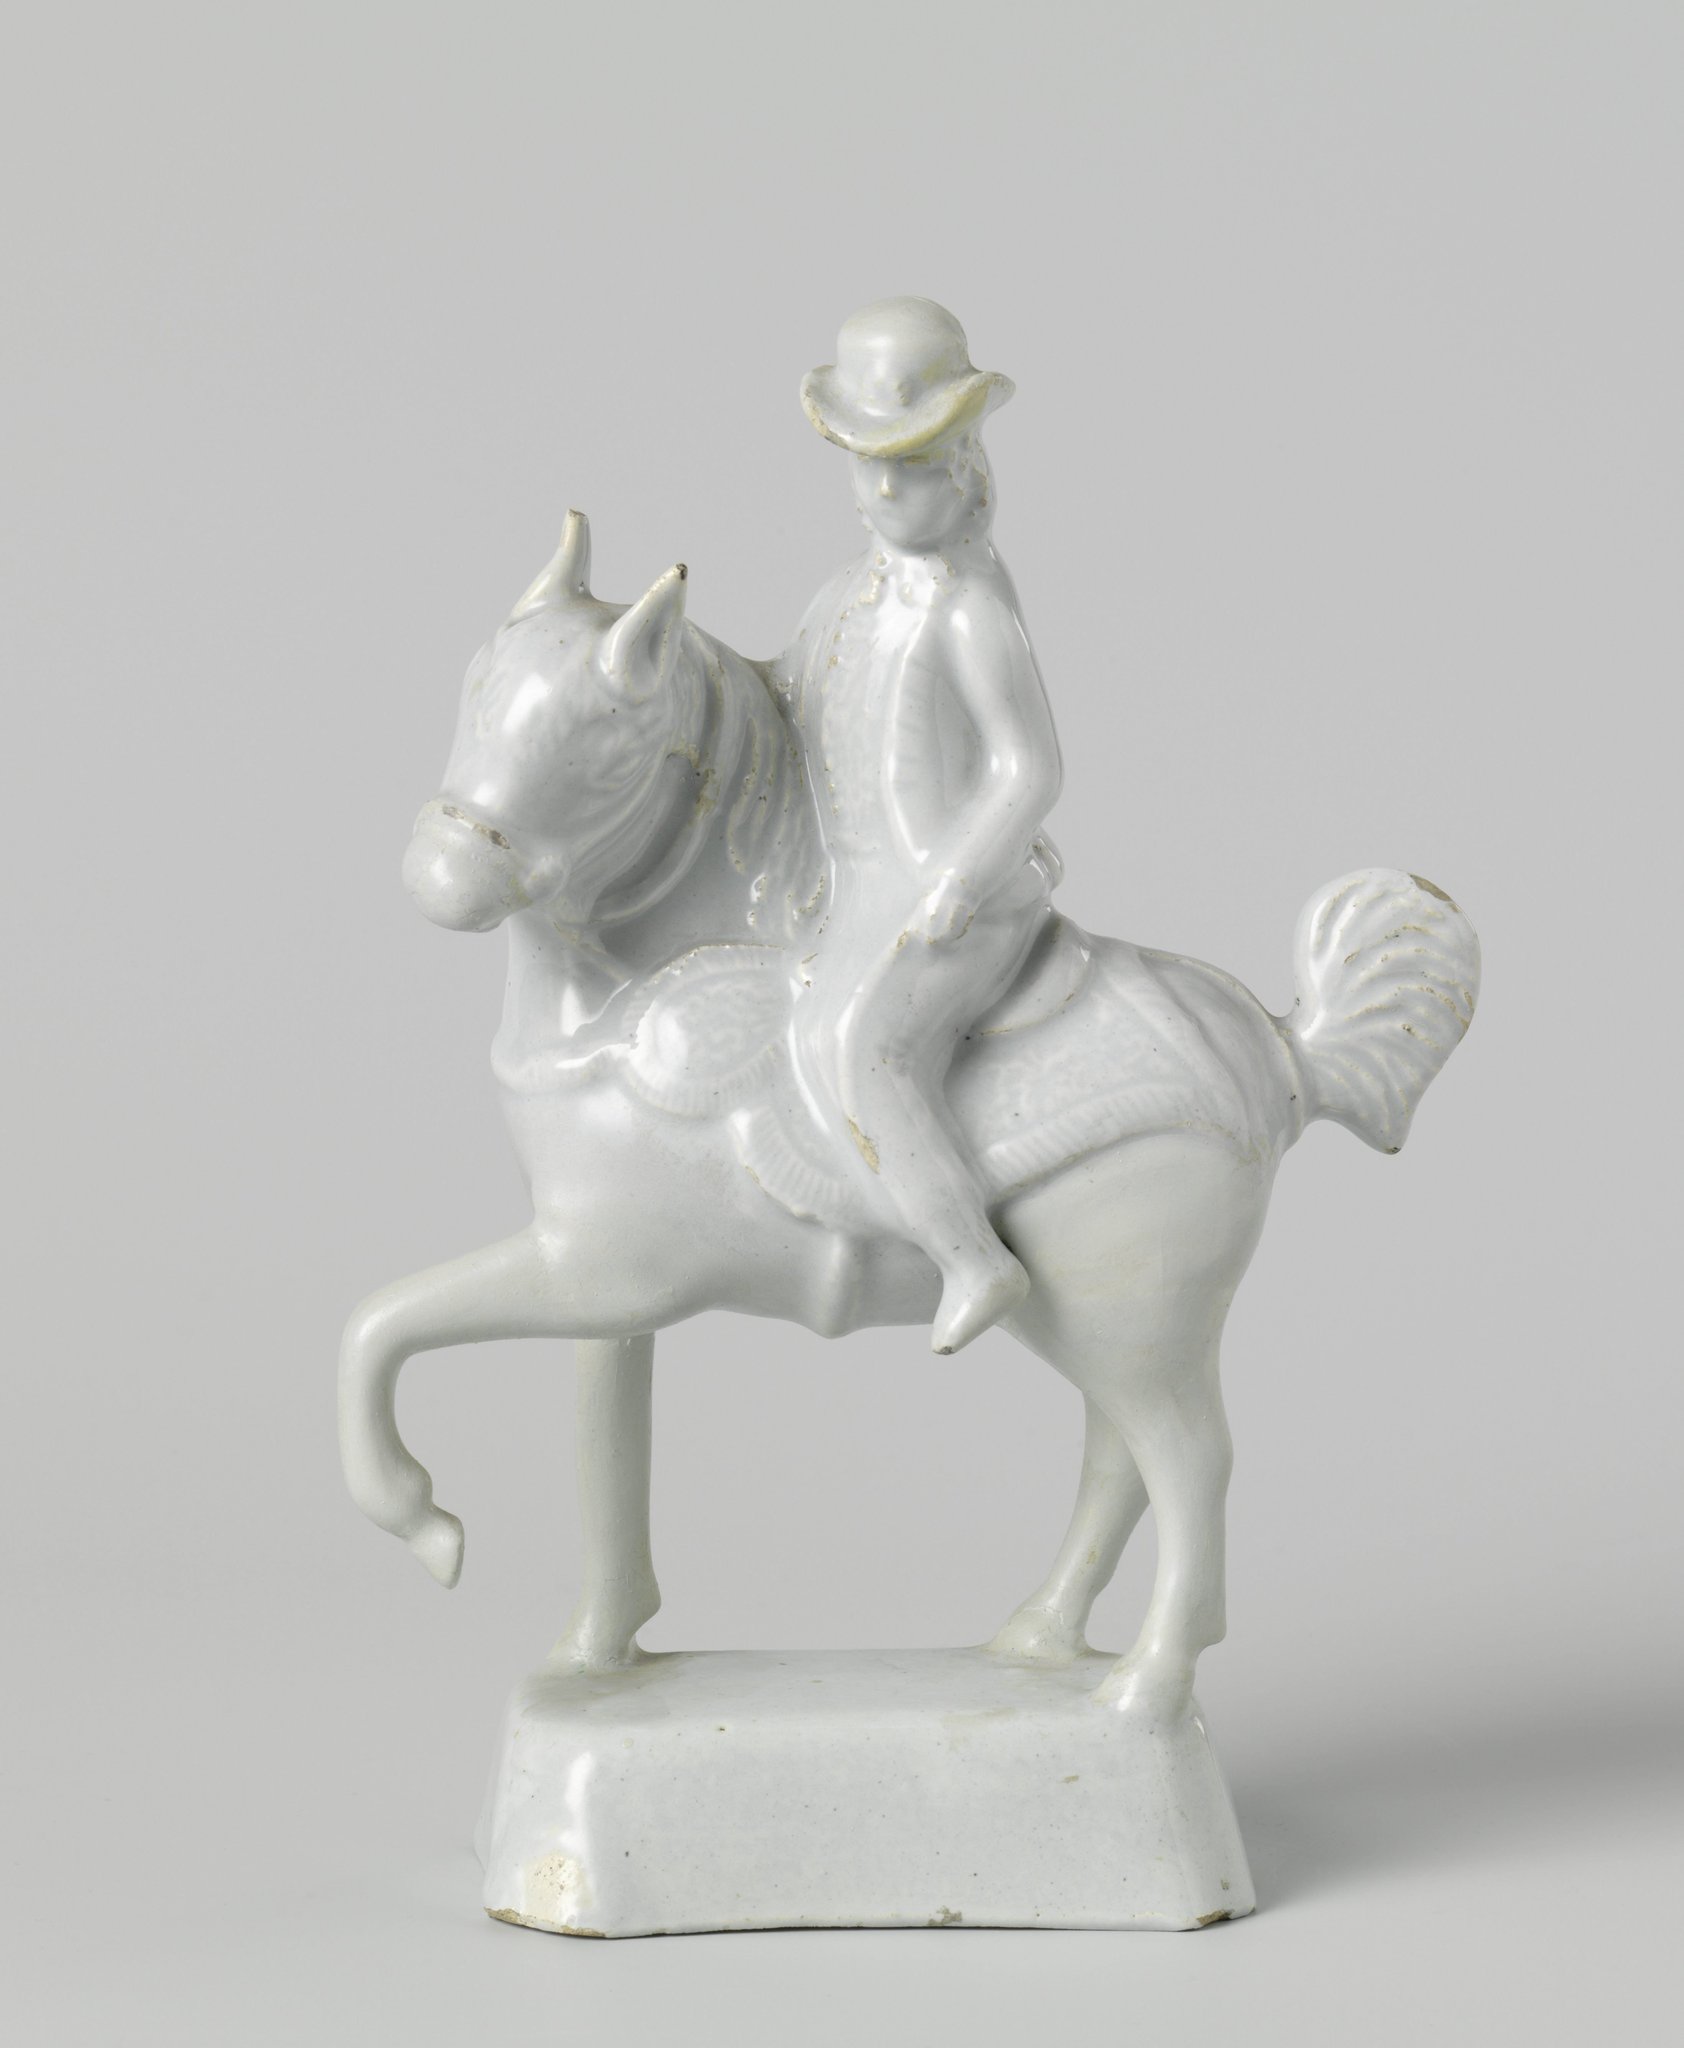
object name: decoratief object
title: Ruiter te paard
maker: Anonymous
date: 1780-1820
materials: earthenware, glaze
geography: delft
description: Beeld van ongedecoreerde faience. Op een rechthoekig voetstuk met afgeschuinde hoeken staat een ruiter te paard. Het paard heeft zijn linker voorbeen gebogen. De ruiter draagt een ronde hoed.